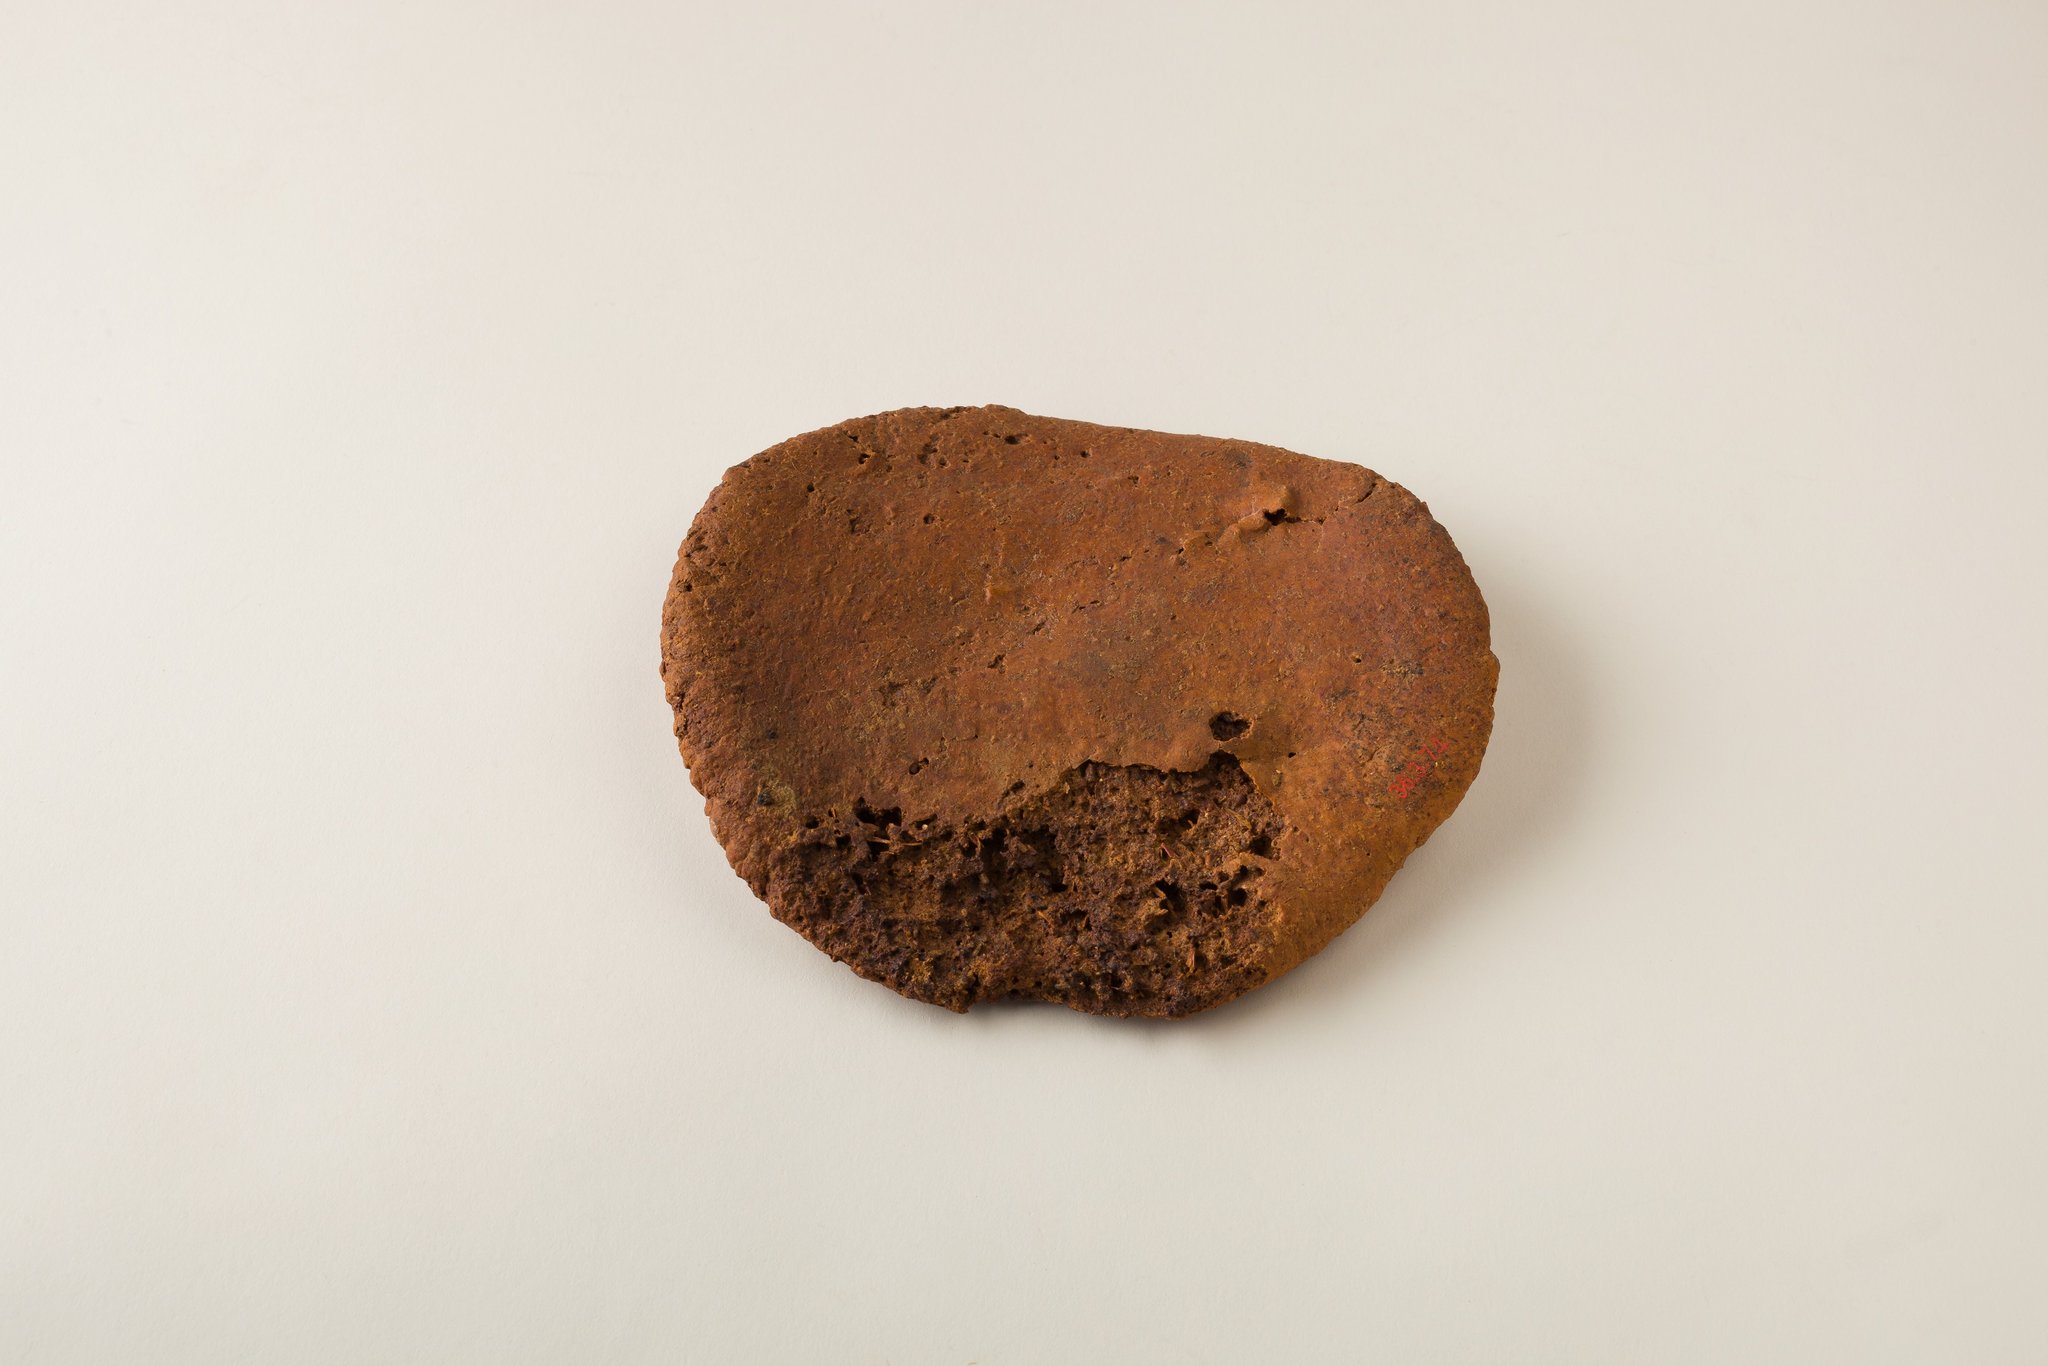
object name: food, bread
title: Loaf of Bread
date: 1492-1473 BCE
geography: egypt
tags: bread